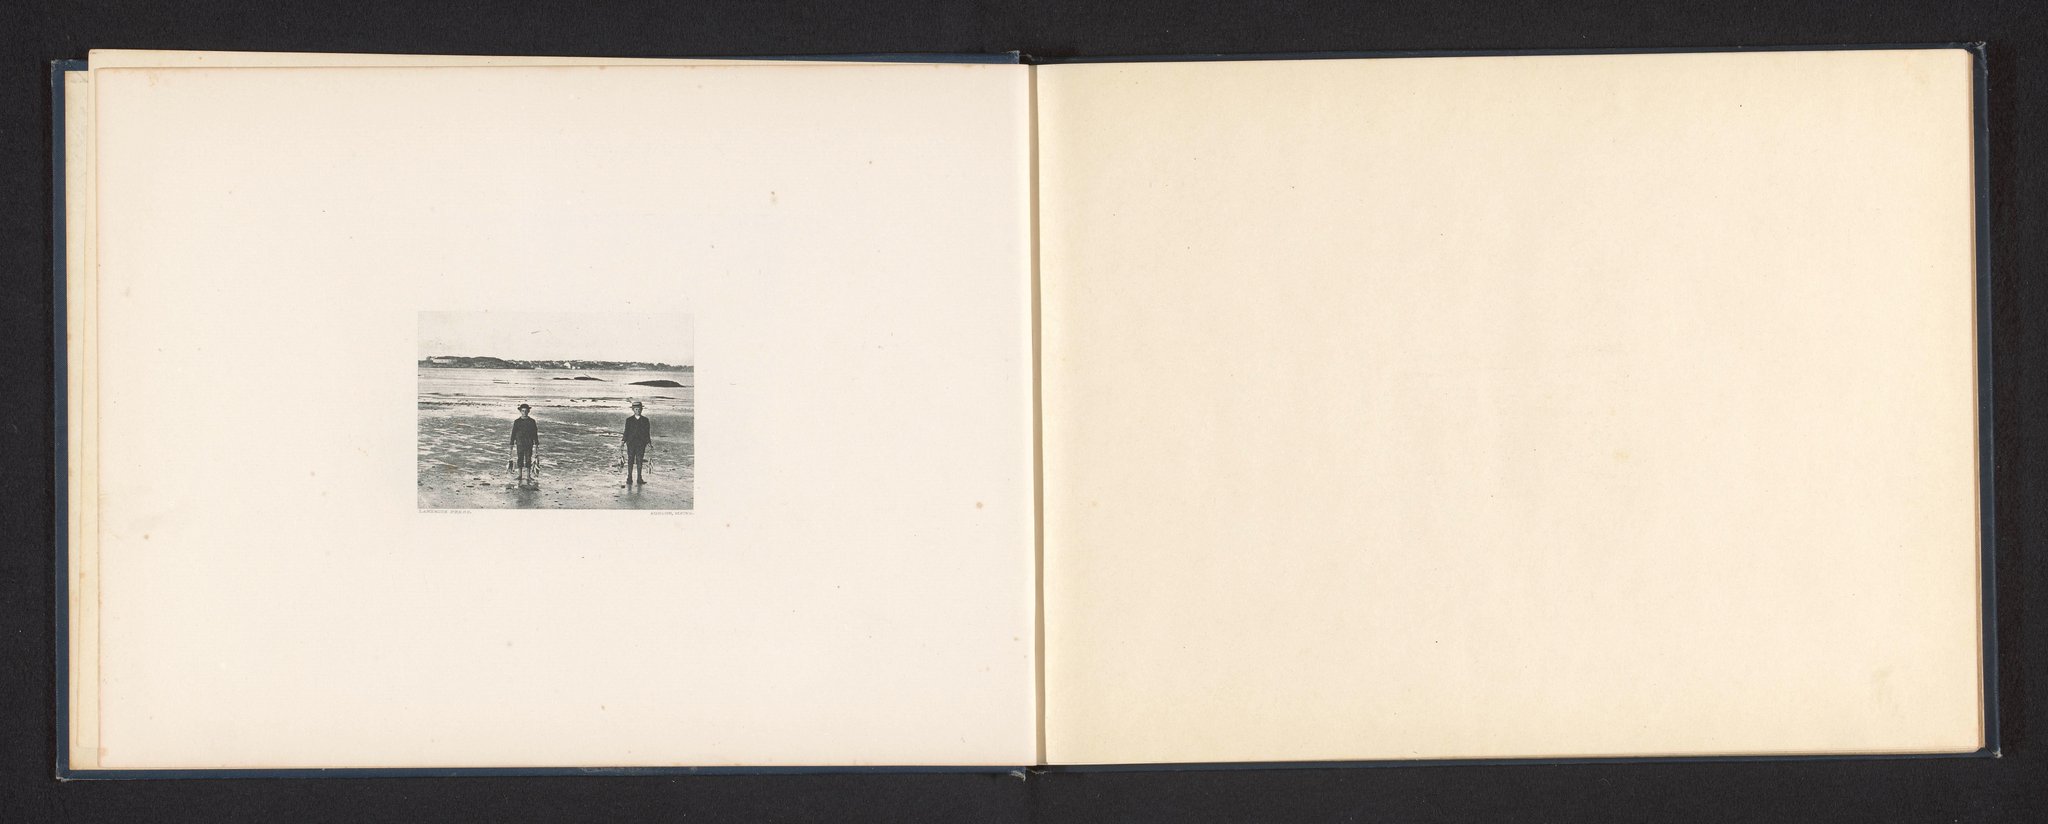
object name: photomechanical print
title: Twee jongens op het strand met vis in de hand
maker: Anonymous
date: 1880-1890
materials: paper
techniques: photoaquatint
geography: maine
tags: fishes, coast, sea